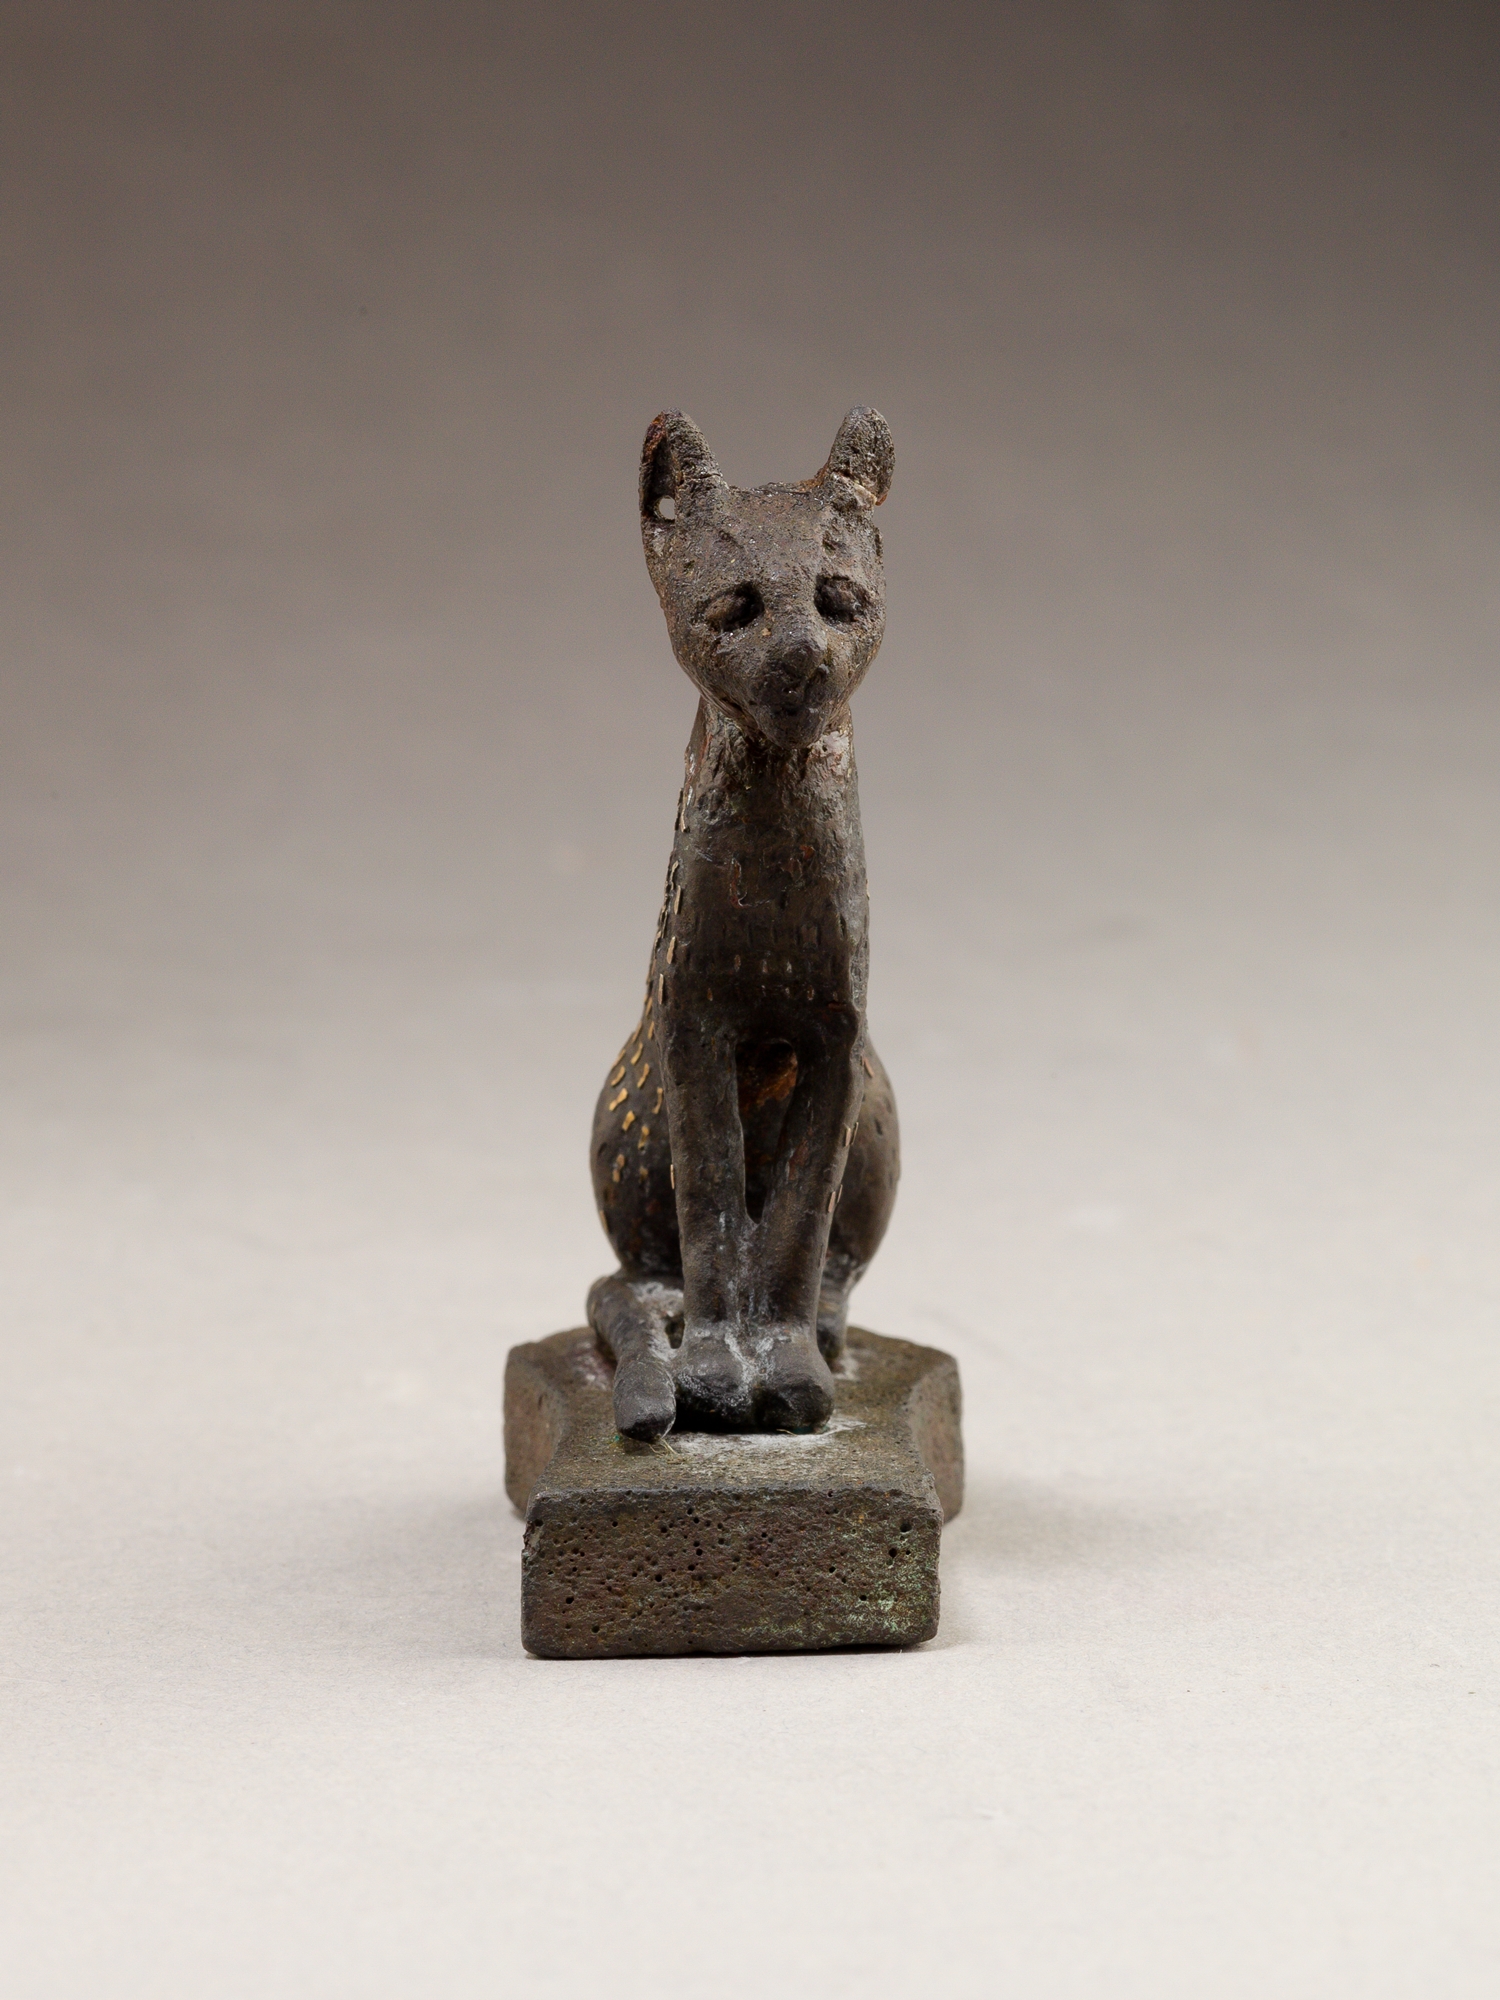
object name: figurine, cat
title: Cat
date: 664-630 BCE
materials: metal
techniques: inlay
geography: egypt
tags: cats